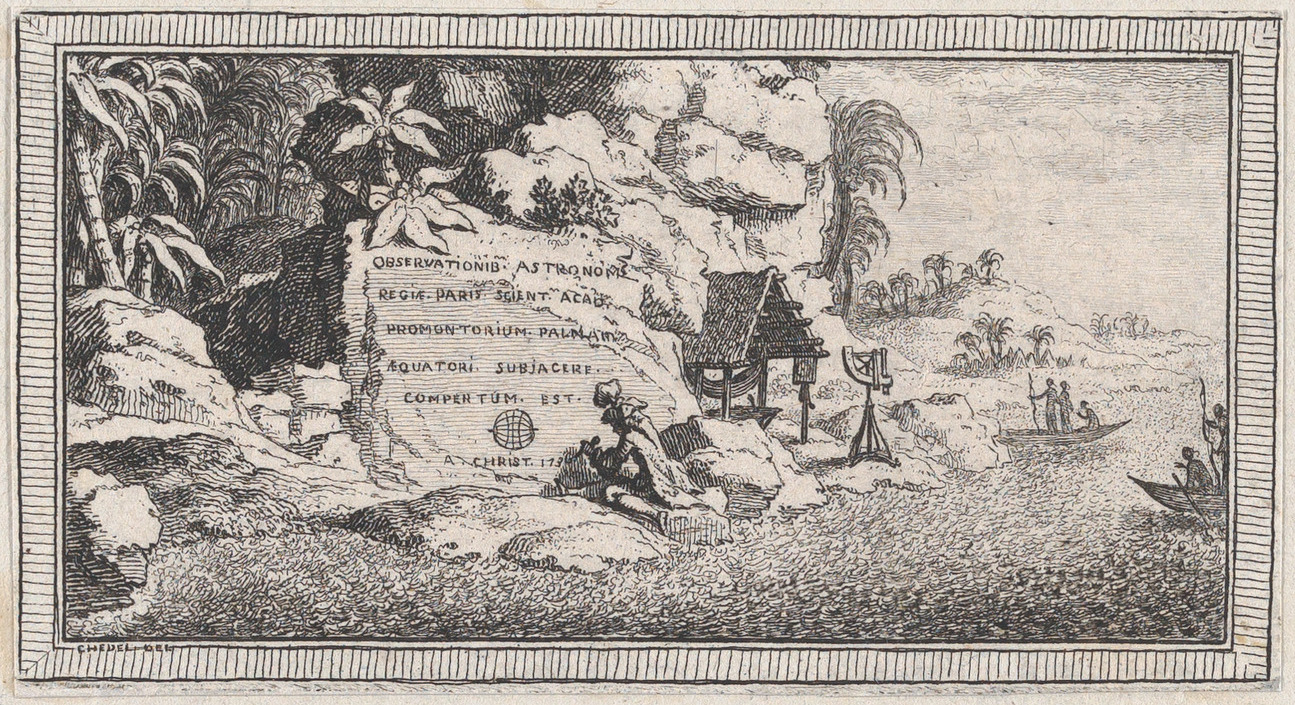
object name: print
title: Title Page, from a series of six landscapes titled "Observationib.Astronom.Regiae.Paris.Scient. Acad...1736"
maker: quentin pierre chedel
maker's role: artist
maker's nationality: french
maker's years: 1705-1763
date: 1736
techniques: etching